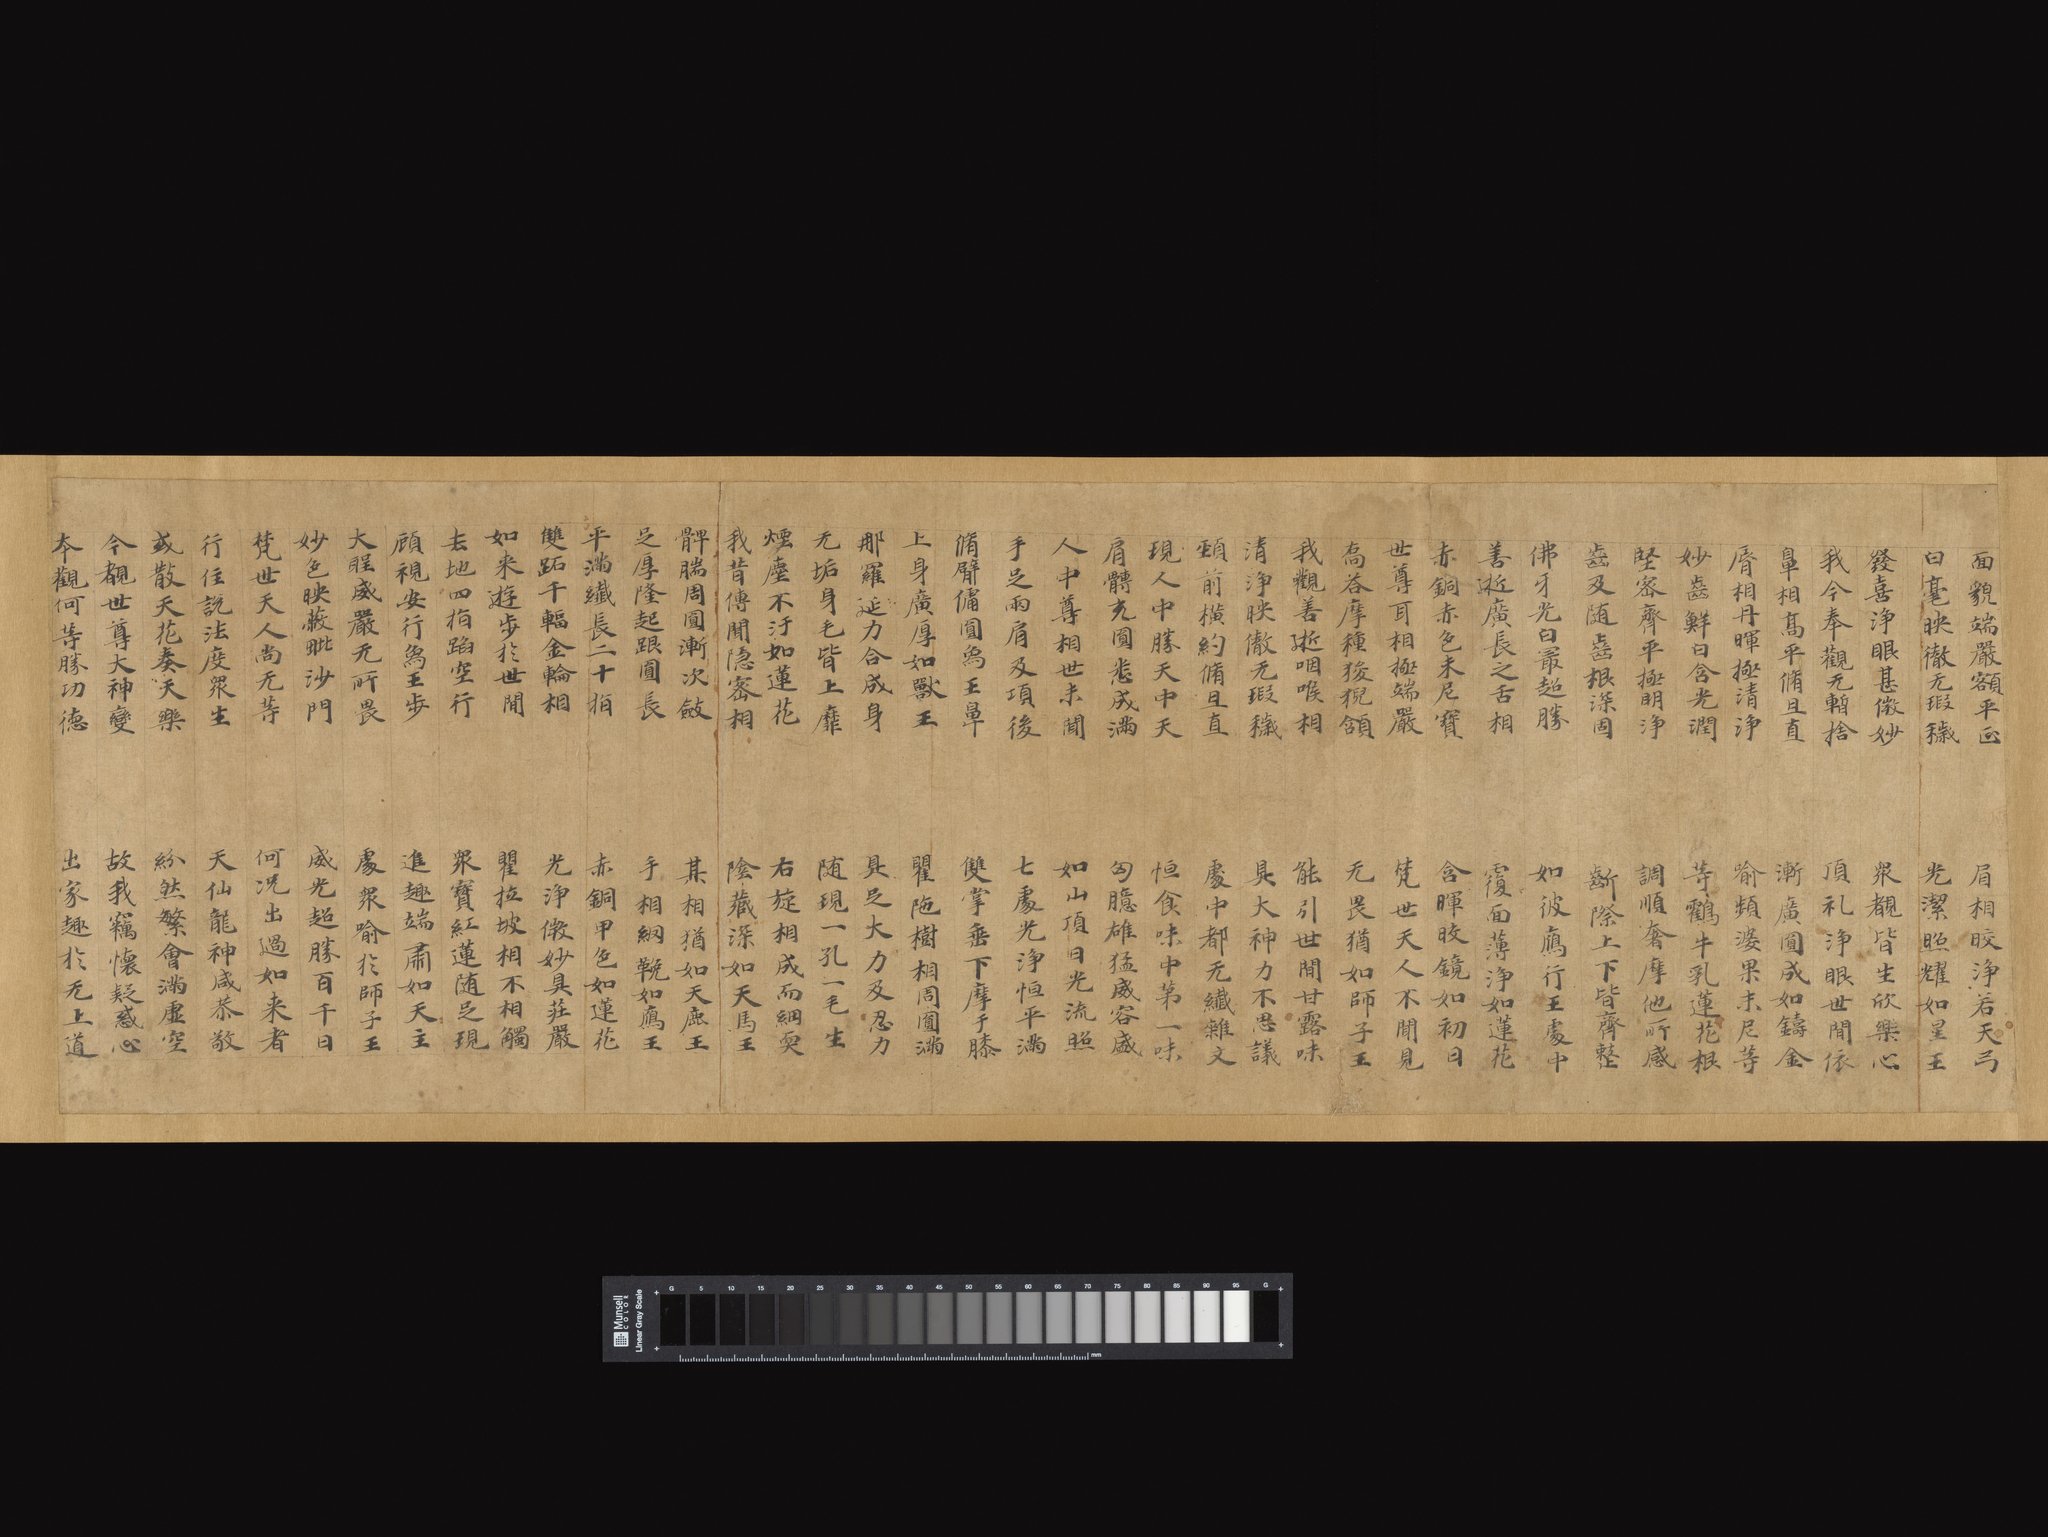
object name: manuscript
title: Fragment of a manuscript of the Sutra of Accumulated Treasures (Dabaoji jing)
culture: chinese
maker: unidentified artist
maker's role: artist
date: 700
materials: ink, paper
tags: calligraphy